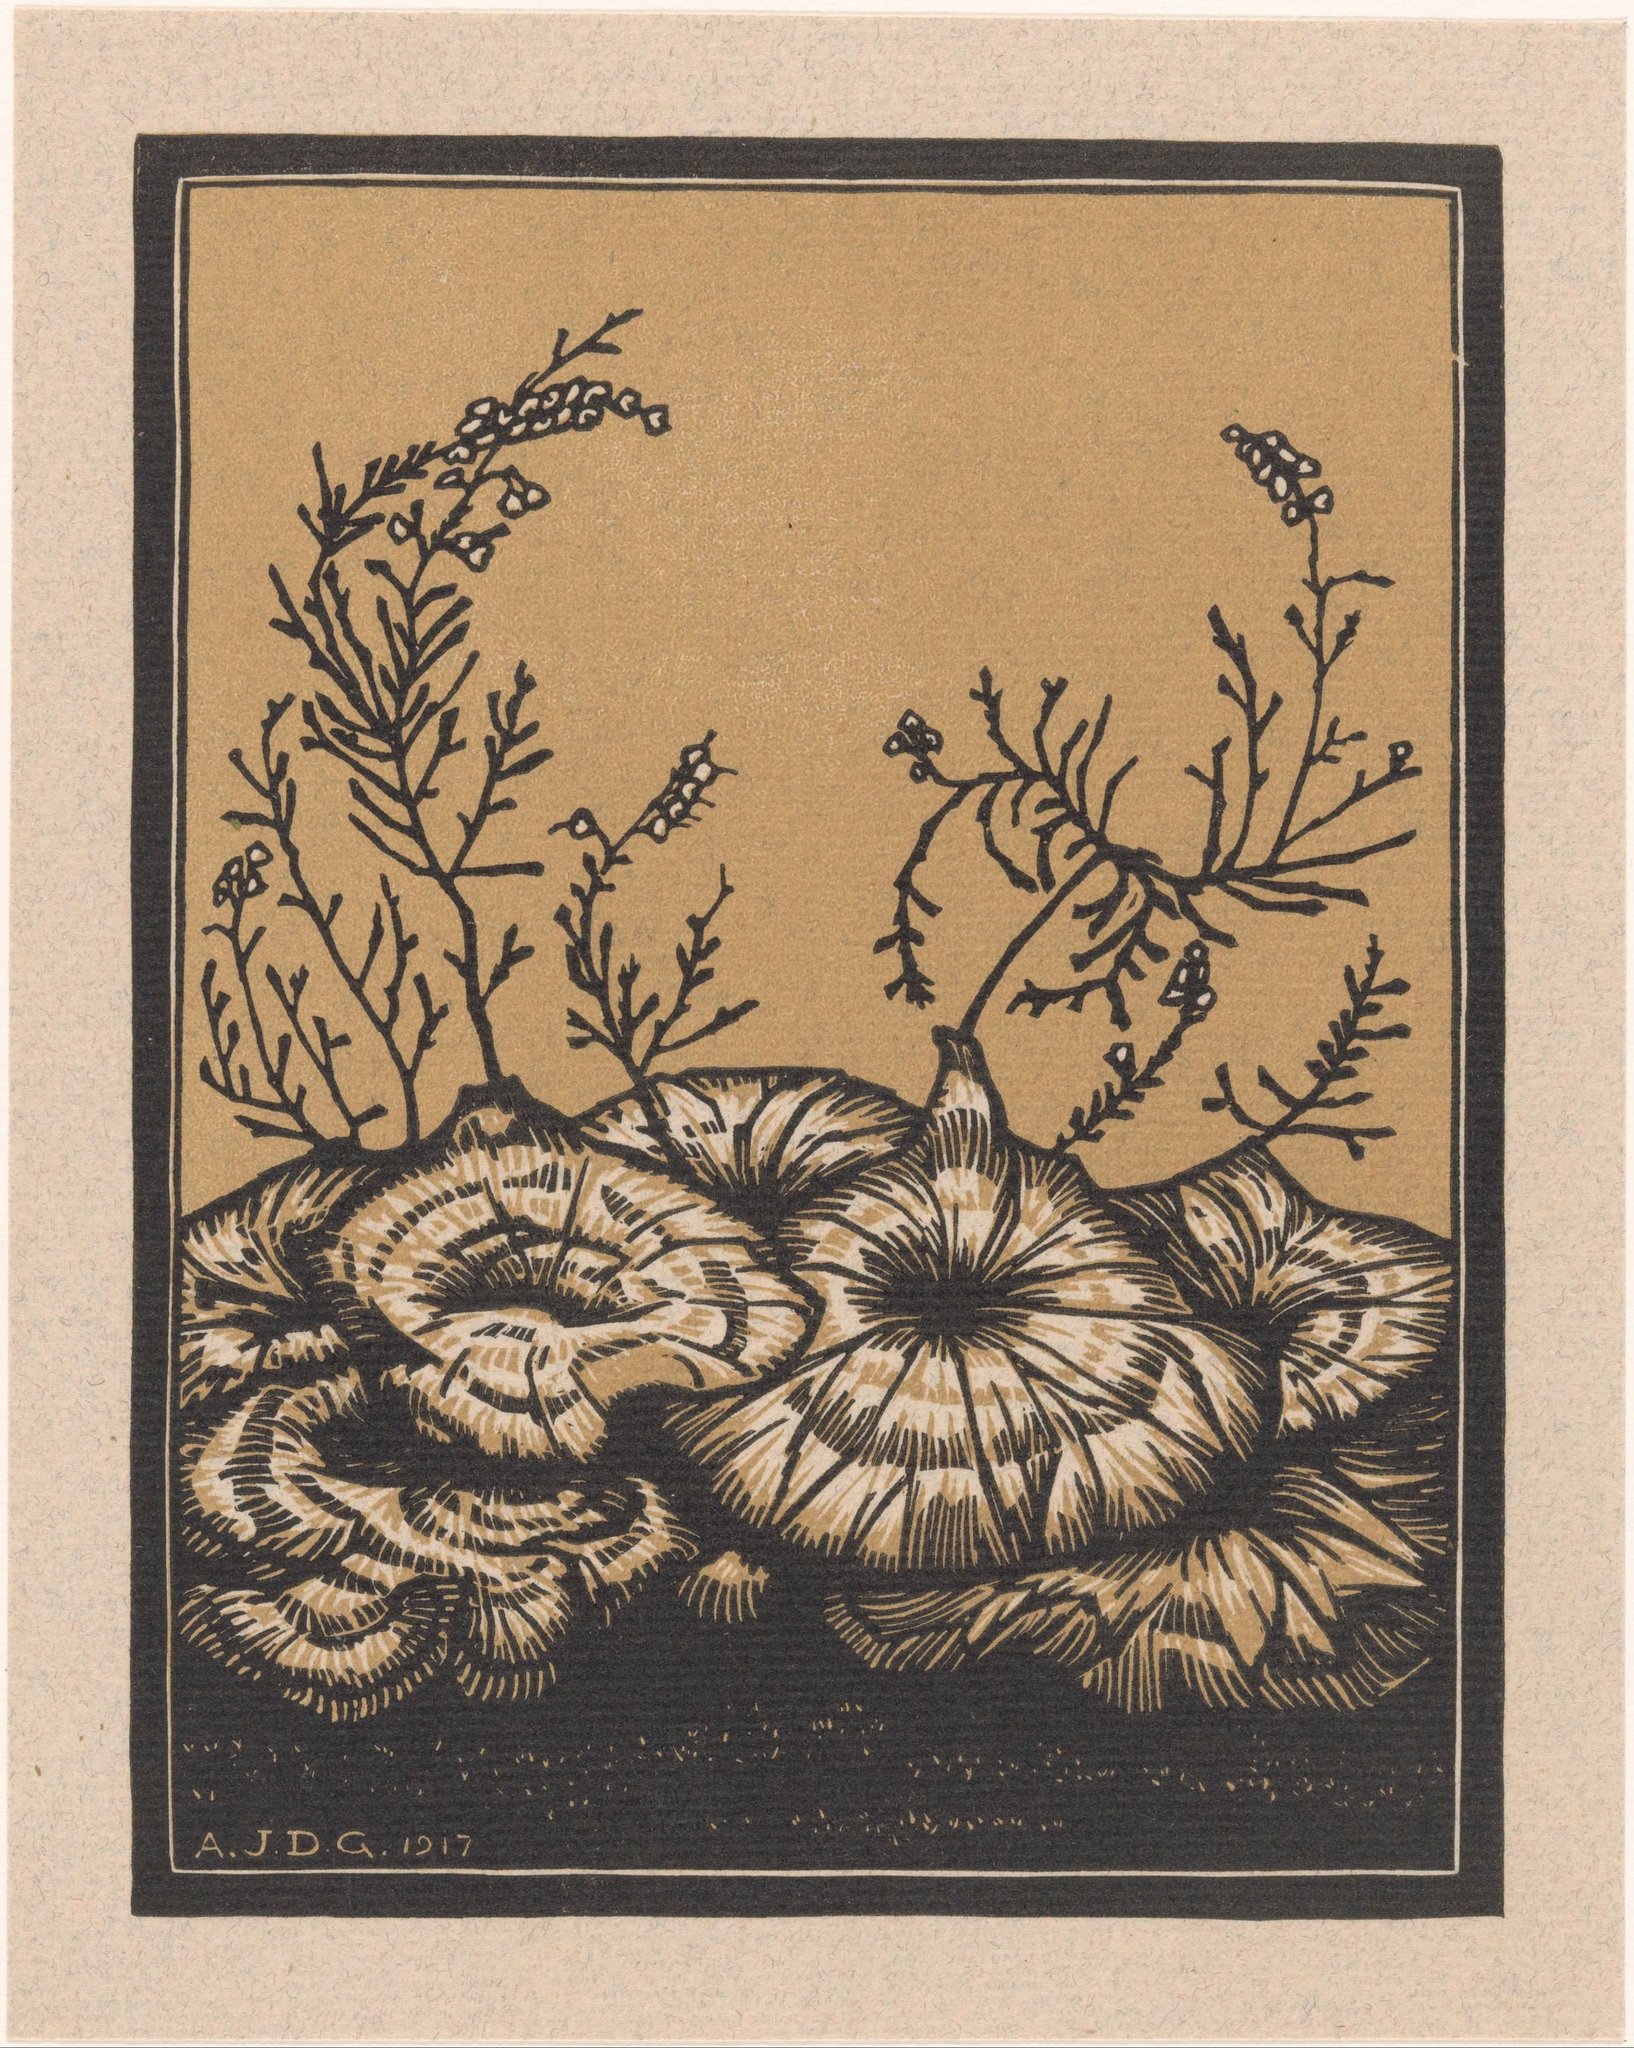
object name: print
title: Bloeiende planten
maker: julie de graag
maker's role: draughtsman, print maker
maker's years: 1877-1924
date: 1917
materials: paper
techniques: woodcut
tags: plants; vegetation (+ flowers, blossom, blossoming)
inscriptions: collector's mark: Lugt 2228